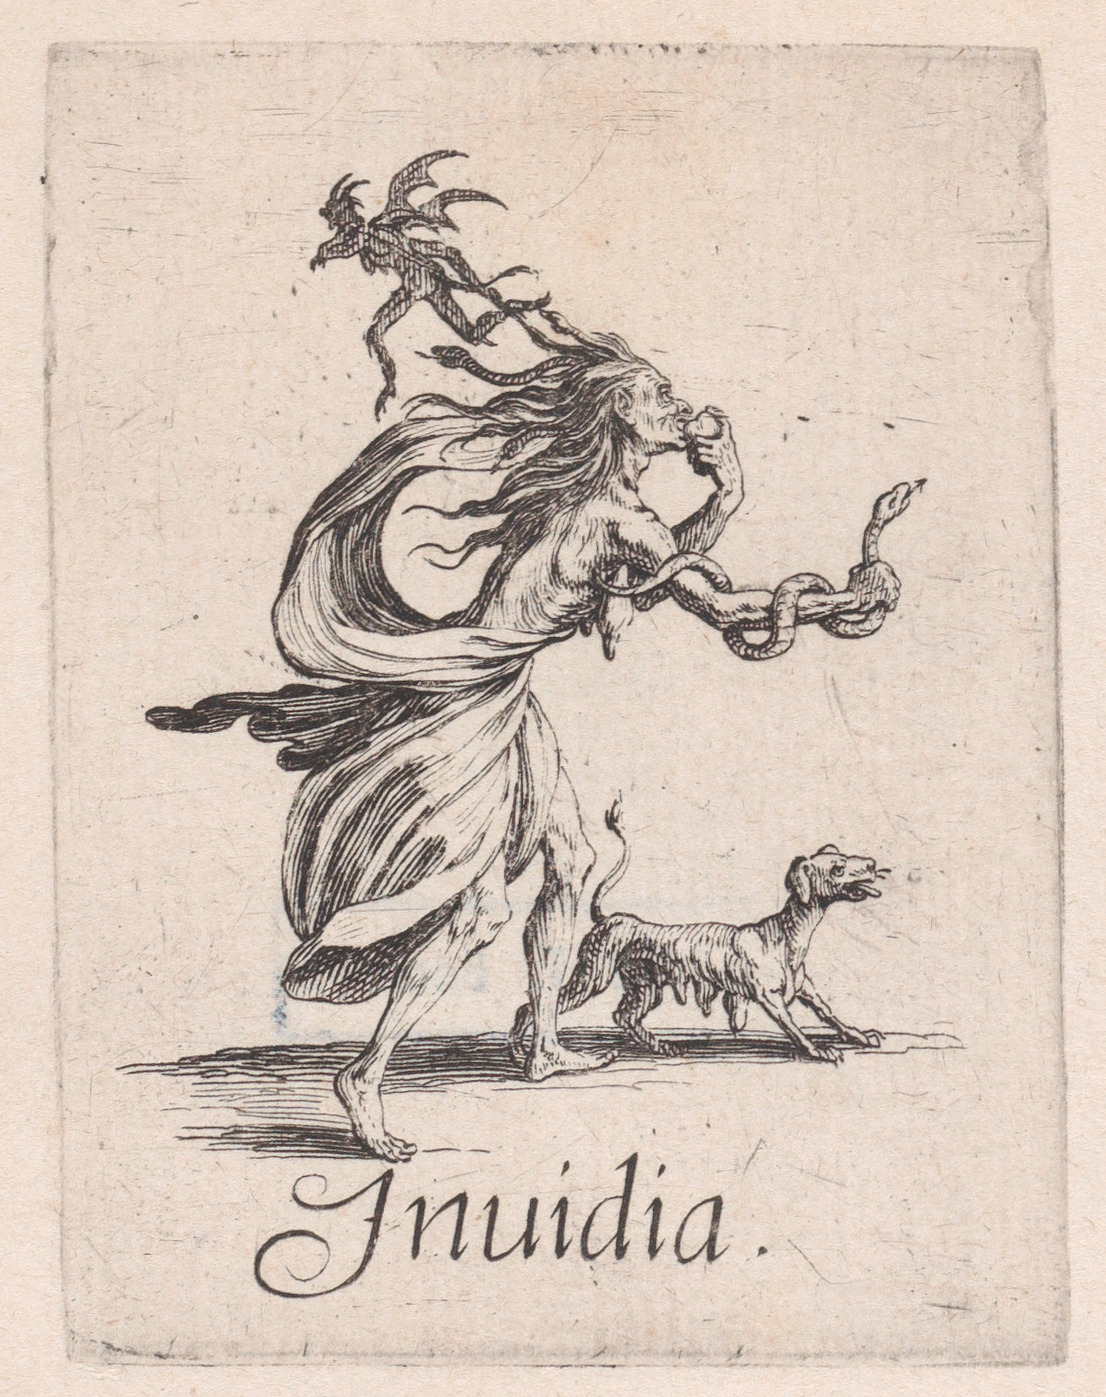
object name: print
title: L'Envie (Envy), from "Les Péchées Capitaux" (The Deadly Sins)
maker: jacques callot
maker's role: artist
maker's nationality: french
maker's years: 1592-1635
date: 1620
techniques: engraving, etching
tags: dogs